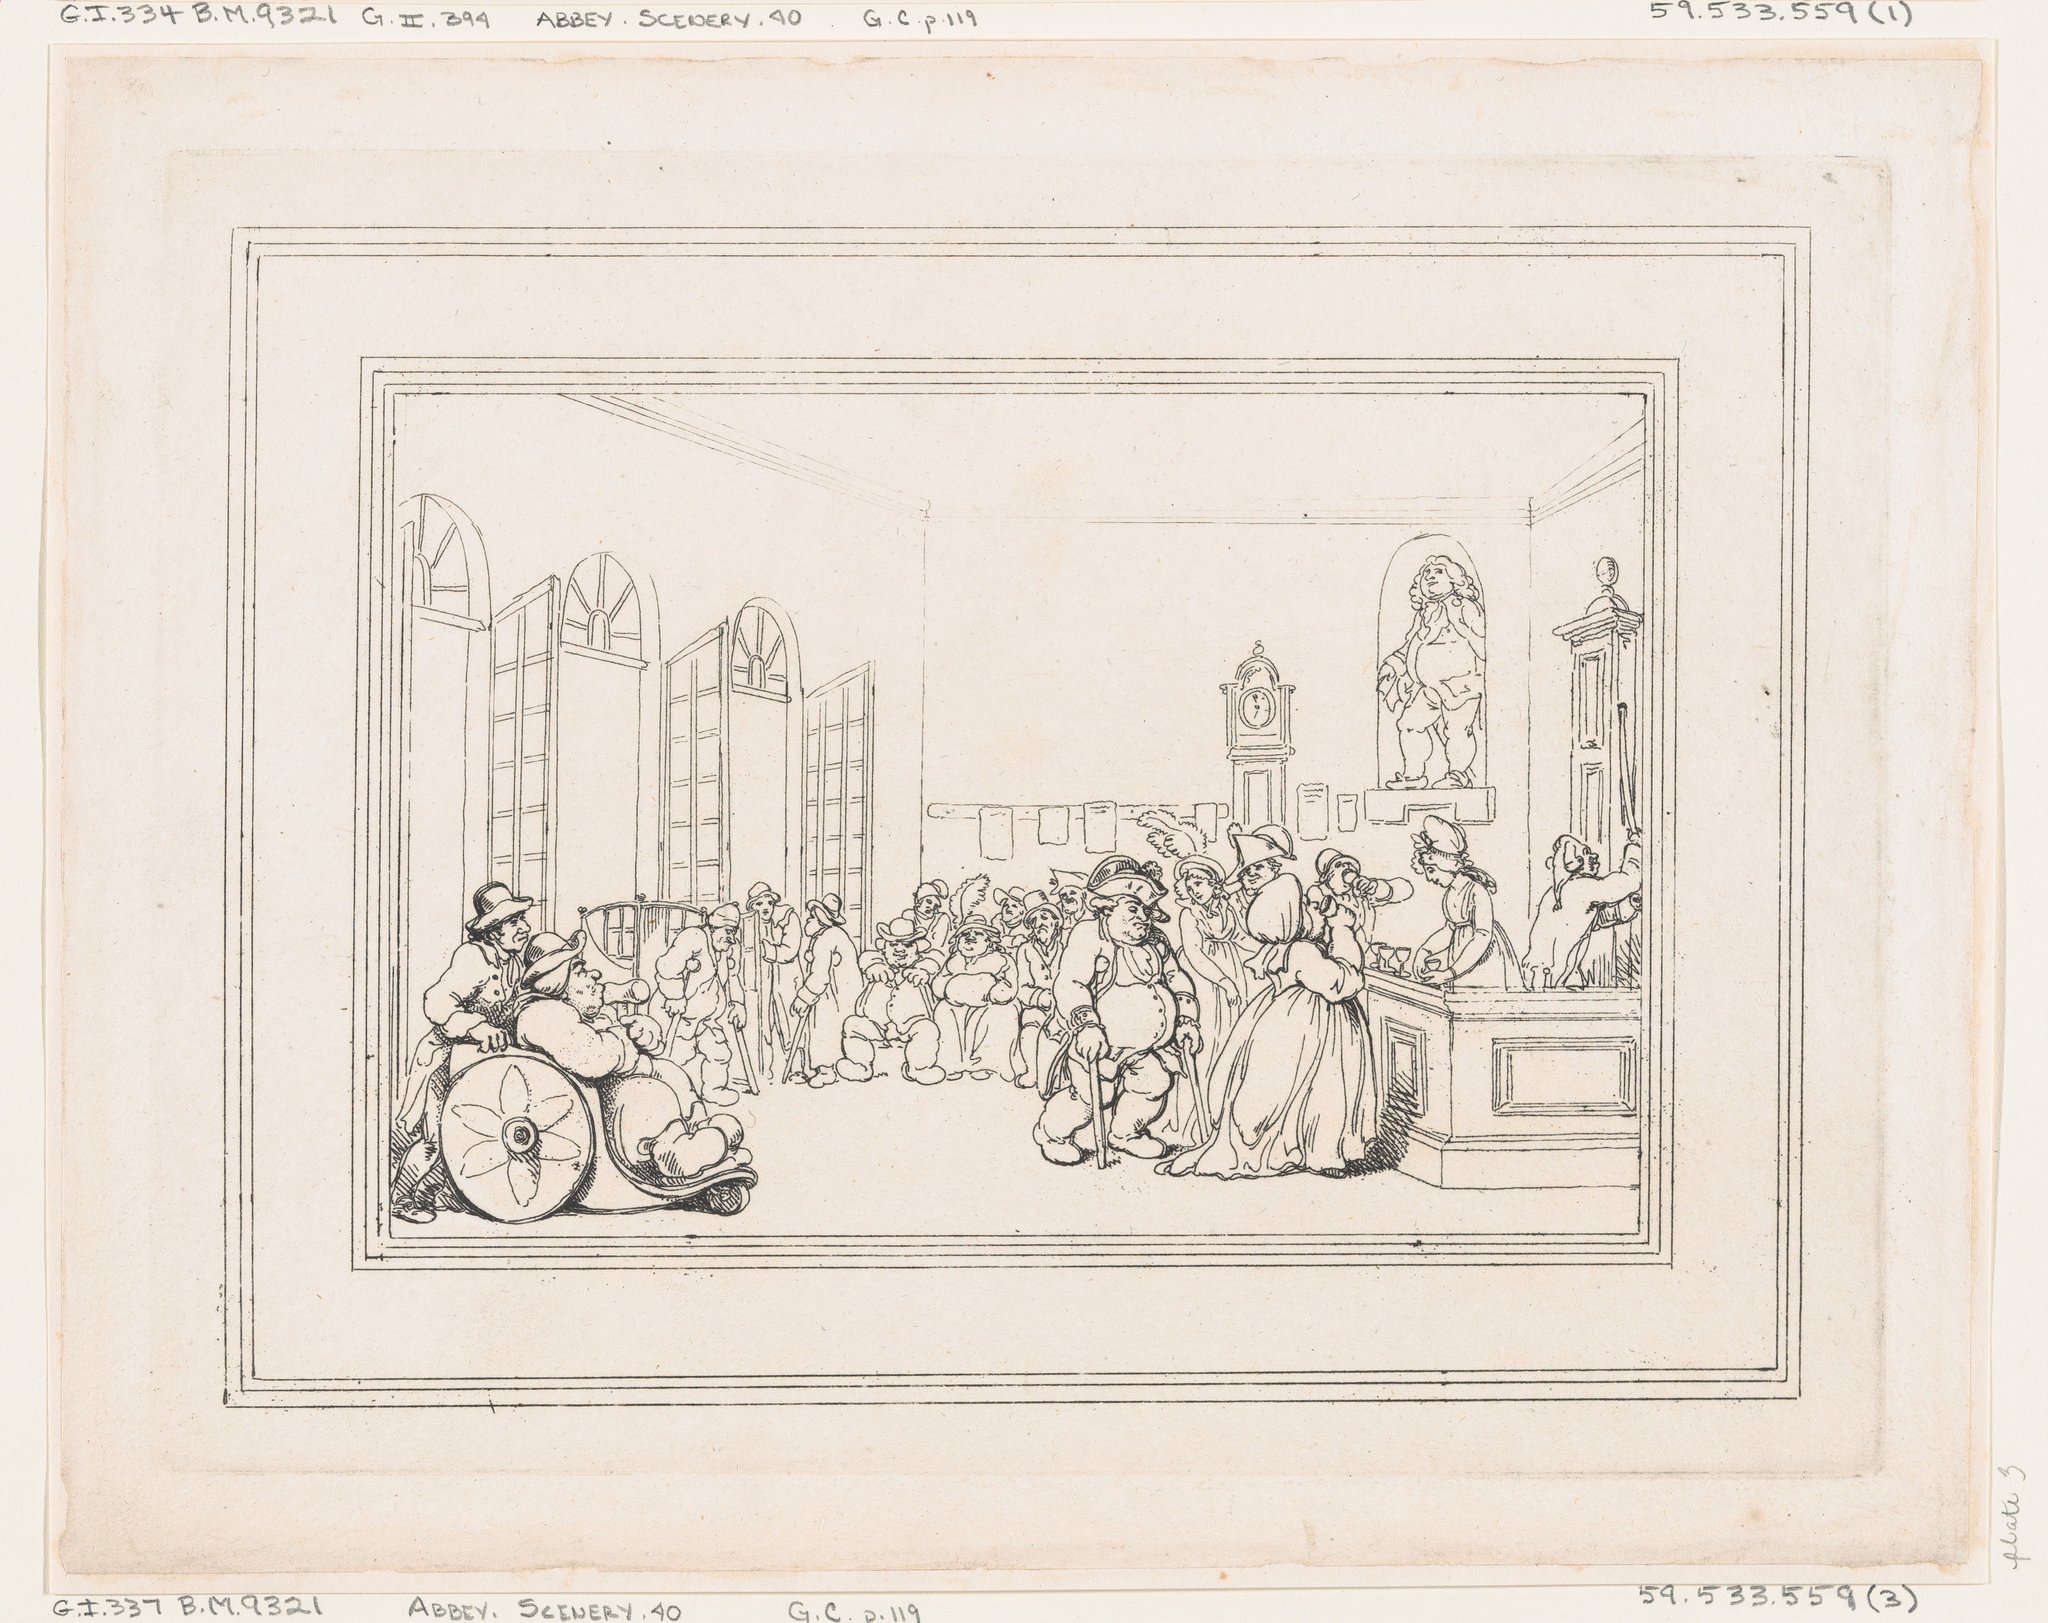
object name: print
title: Comforts of Bath, Plate 3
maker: thomas rowlandson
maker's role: artist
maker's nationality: british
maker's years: 1757-1827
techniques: etching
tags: doors,men,women,crowd